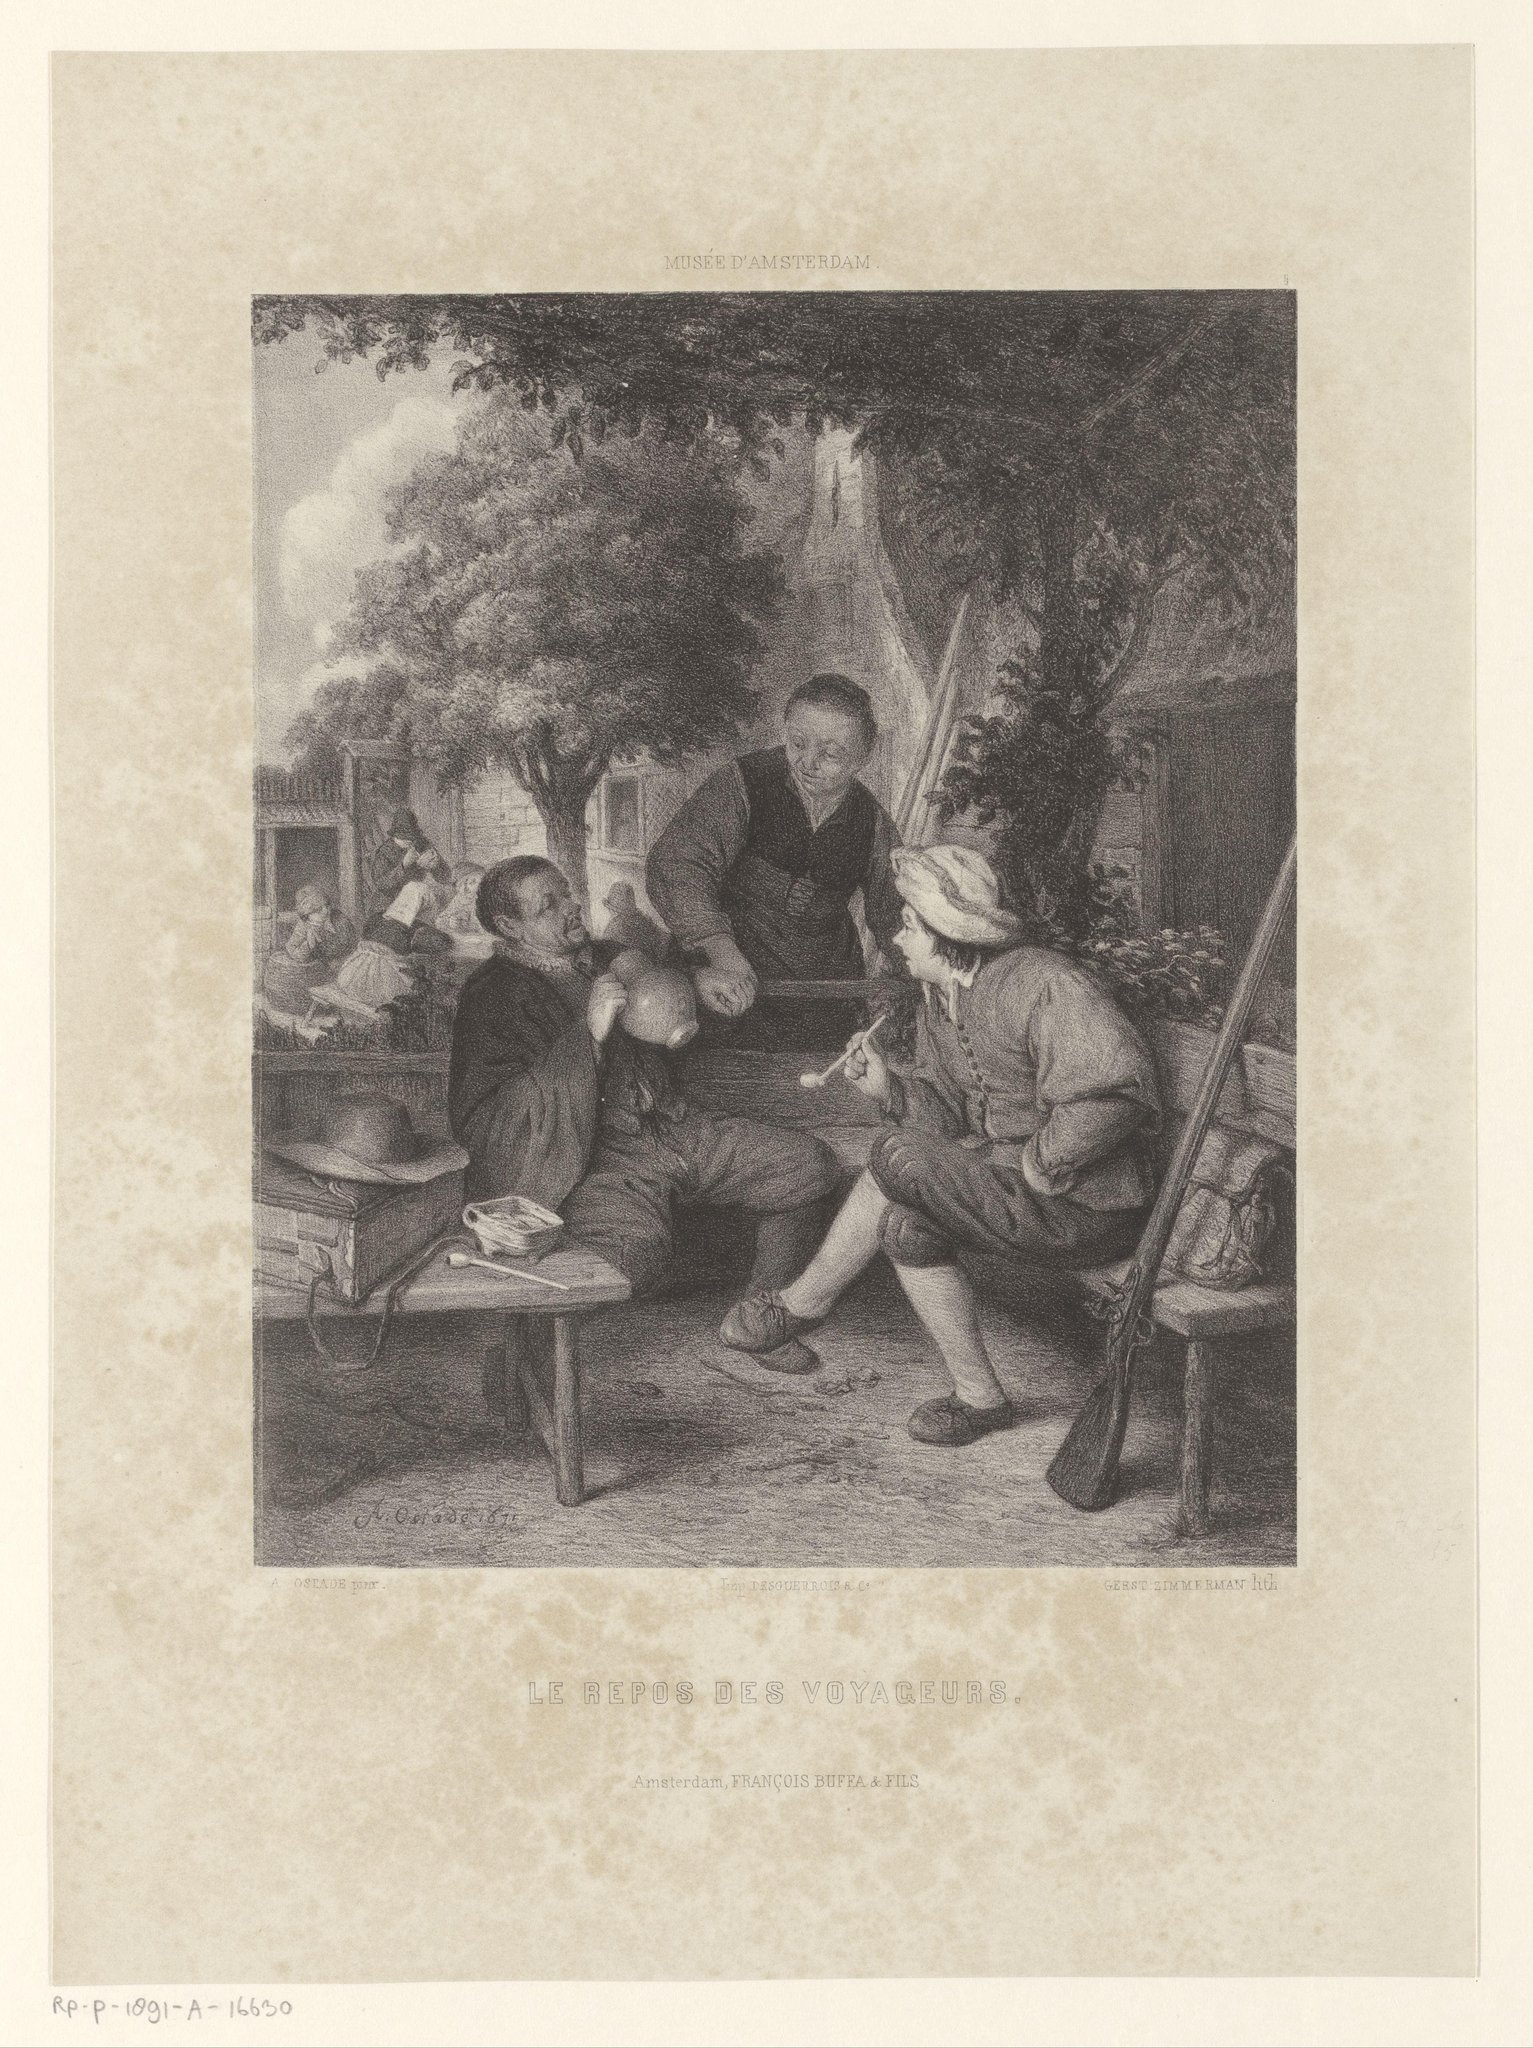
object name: print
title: Rustende reizigers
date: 1826-1887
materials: paper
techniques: lithograph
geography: amsterdam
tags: inn, coffee-house, public house, etc., pipe ~ tobacco, jar, jug (used as drinking-vessel), (traveller) resting in the open air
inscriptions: collector's mark: Lugt 2228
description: Rustende reizigers. Gezeten op een bankje op het terras van een herberg maken twee mannen een praatje met elkaar, tussen hen staat een waardin. De reiziger links heeft zijn koffer en hoed op een tafeltje gelegd en drinkt uit een kruik, de man rechts, een jager, rookt een pijp met naast hem zijn jachtgeweer en jachttas.